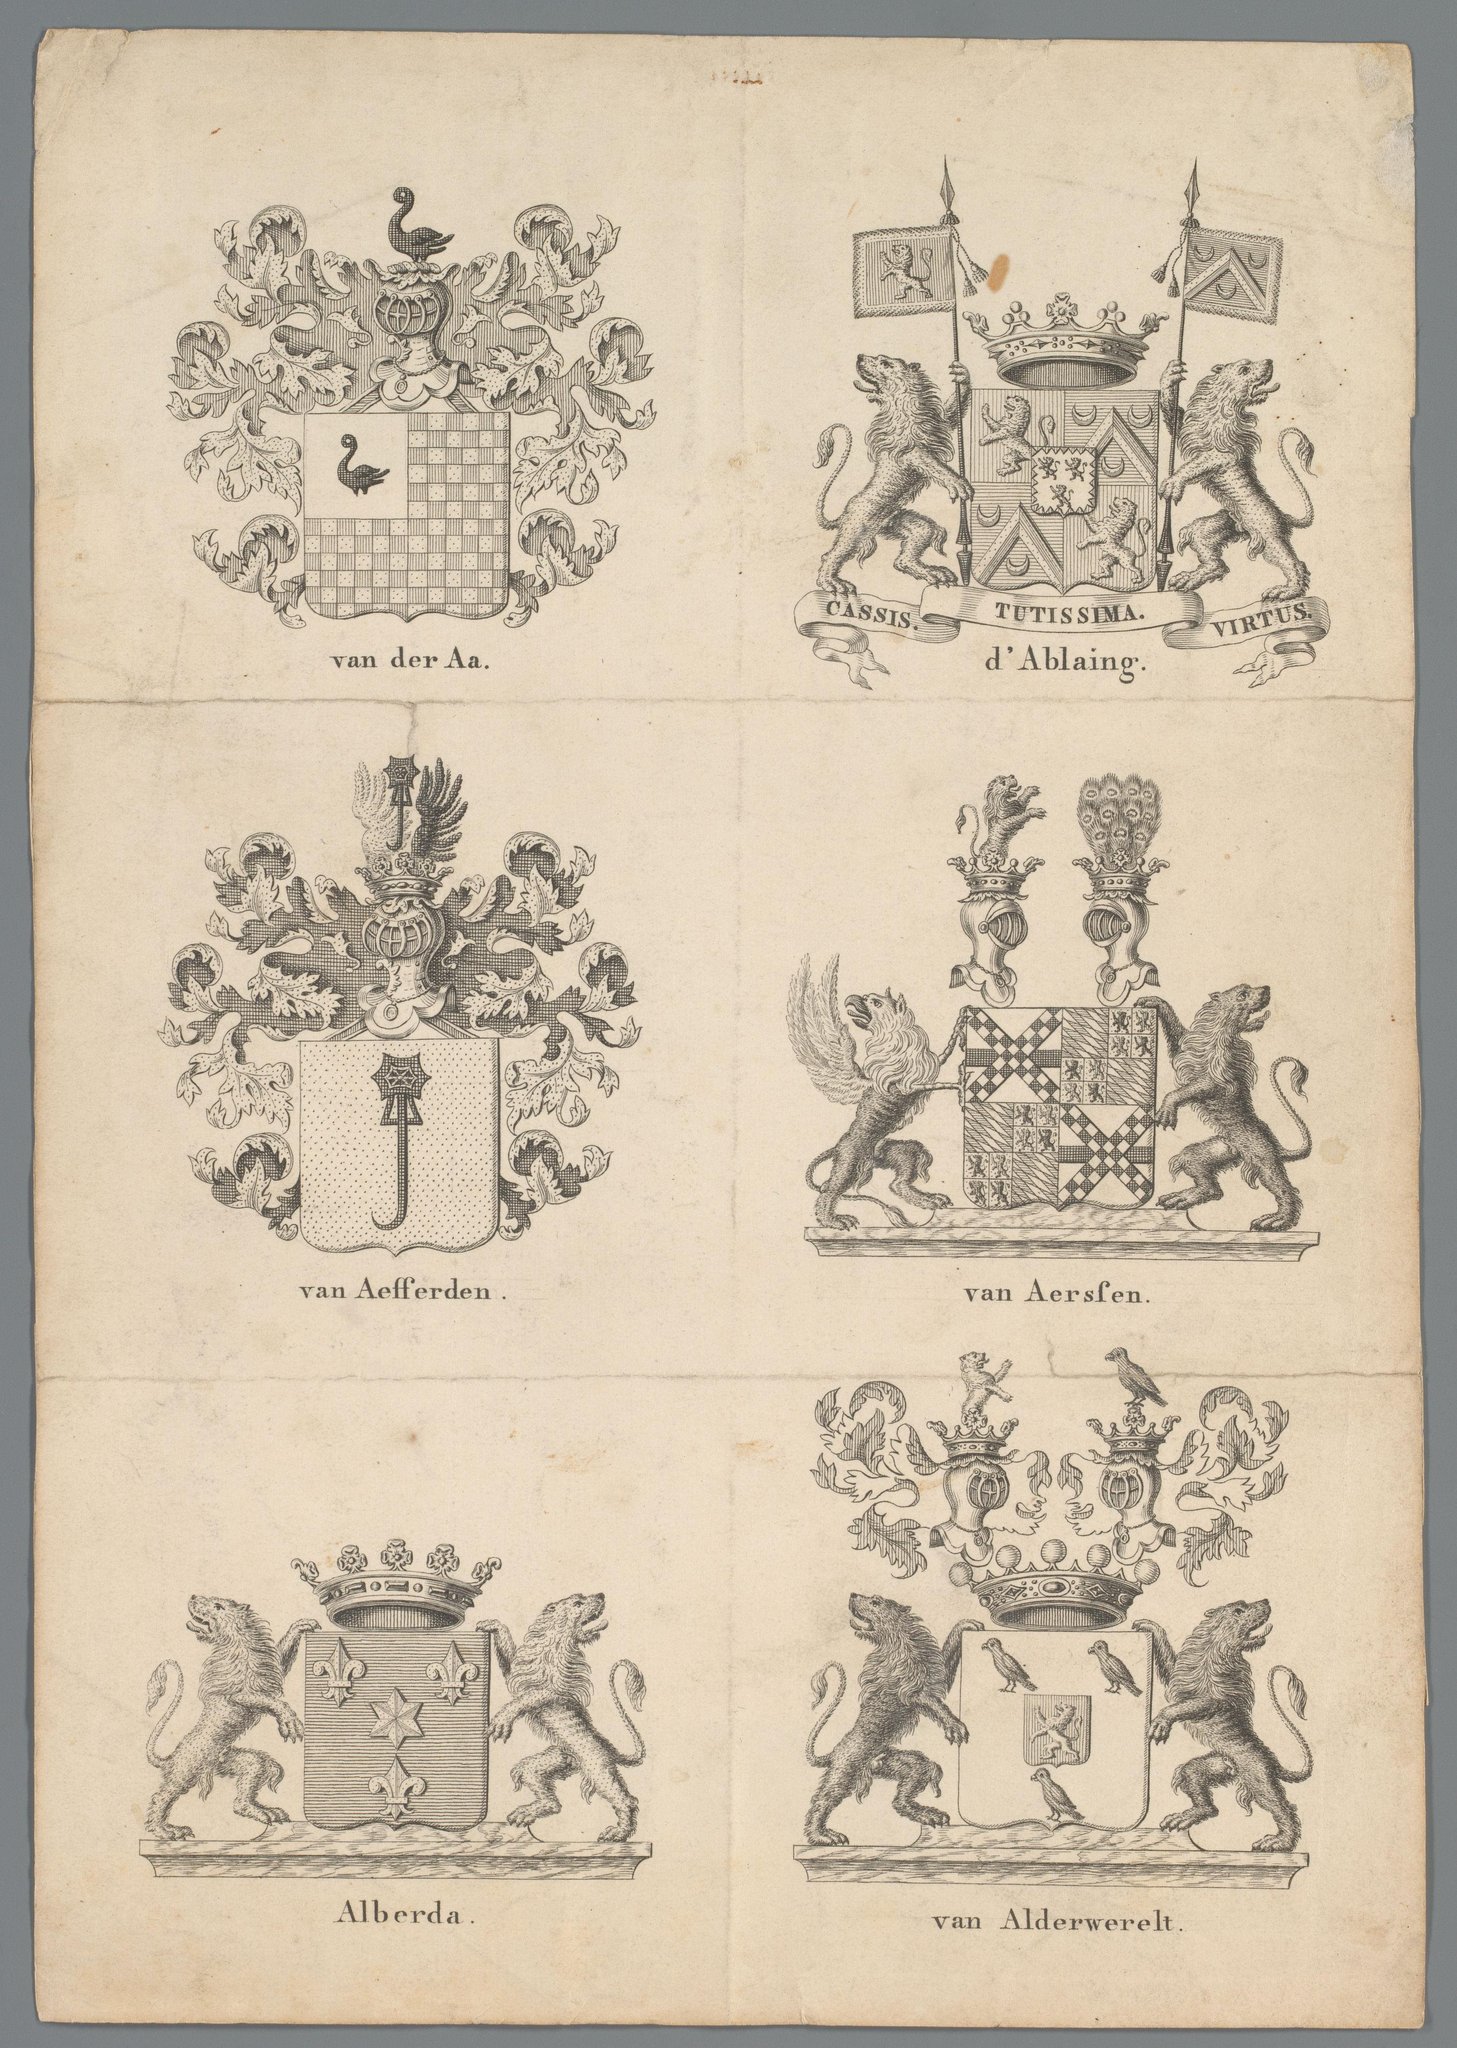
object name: print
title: Zes wapenschilden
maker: Anonymous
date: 1750-1849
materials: paper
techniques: engraving, etching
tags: armorial bearing, heraldry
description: Wapens van de geslachten Van der Aa, D'Ablaing, Van Aefferden, Van Aerssen, Alberda en Van Alderwerelt.